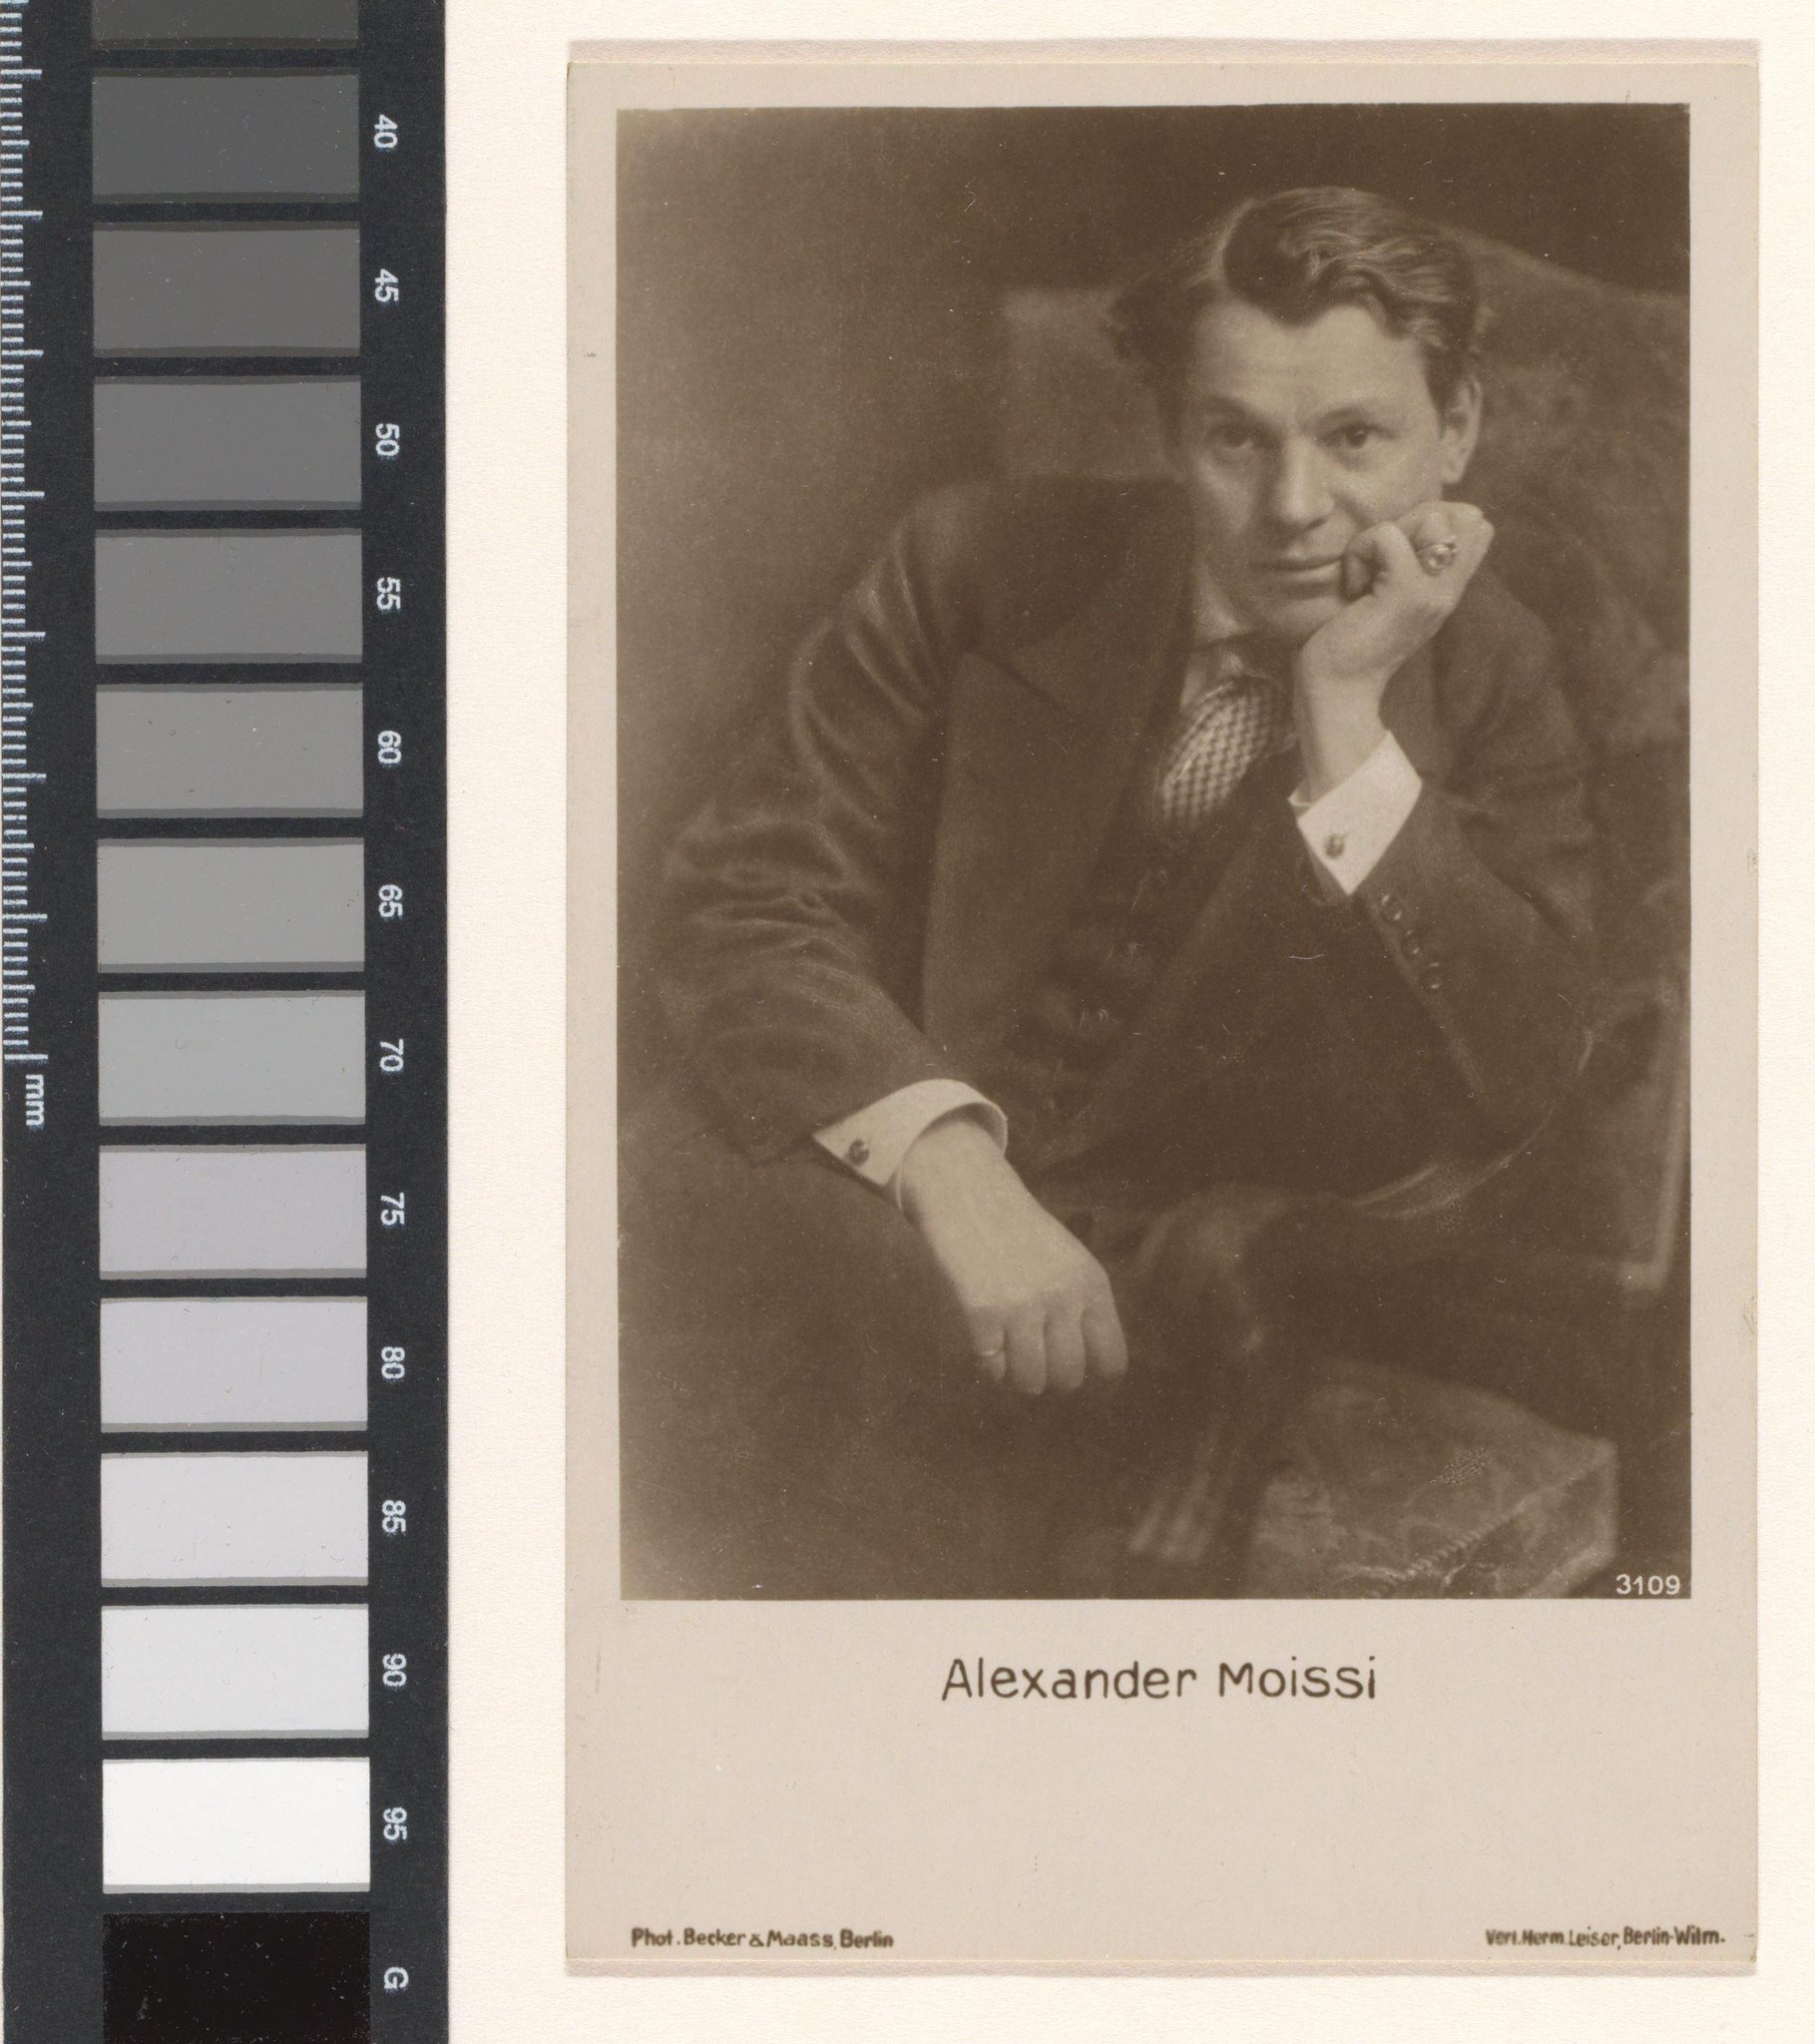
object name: ansichtkaart, prentbriefkaart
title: Alexander Moissi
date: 1905-1930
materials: paper, cardboard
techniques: gelatin silver print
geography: berlin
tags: historical persons, portrait of actor, actress, berlin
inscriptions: number: ‘3109’, inscription: ‘Alexander Moissi/ Oostenrijks acteur/ 1880-1935’